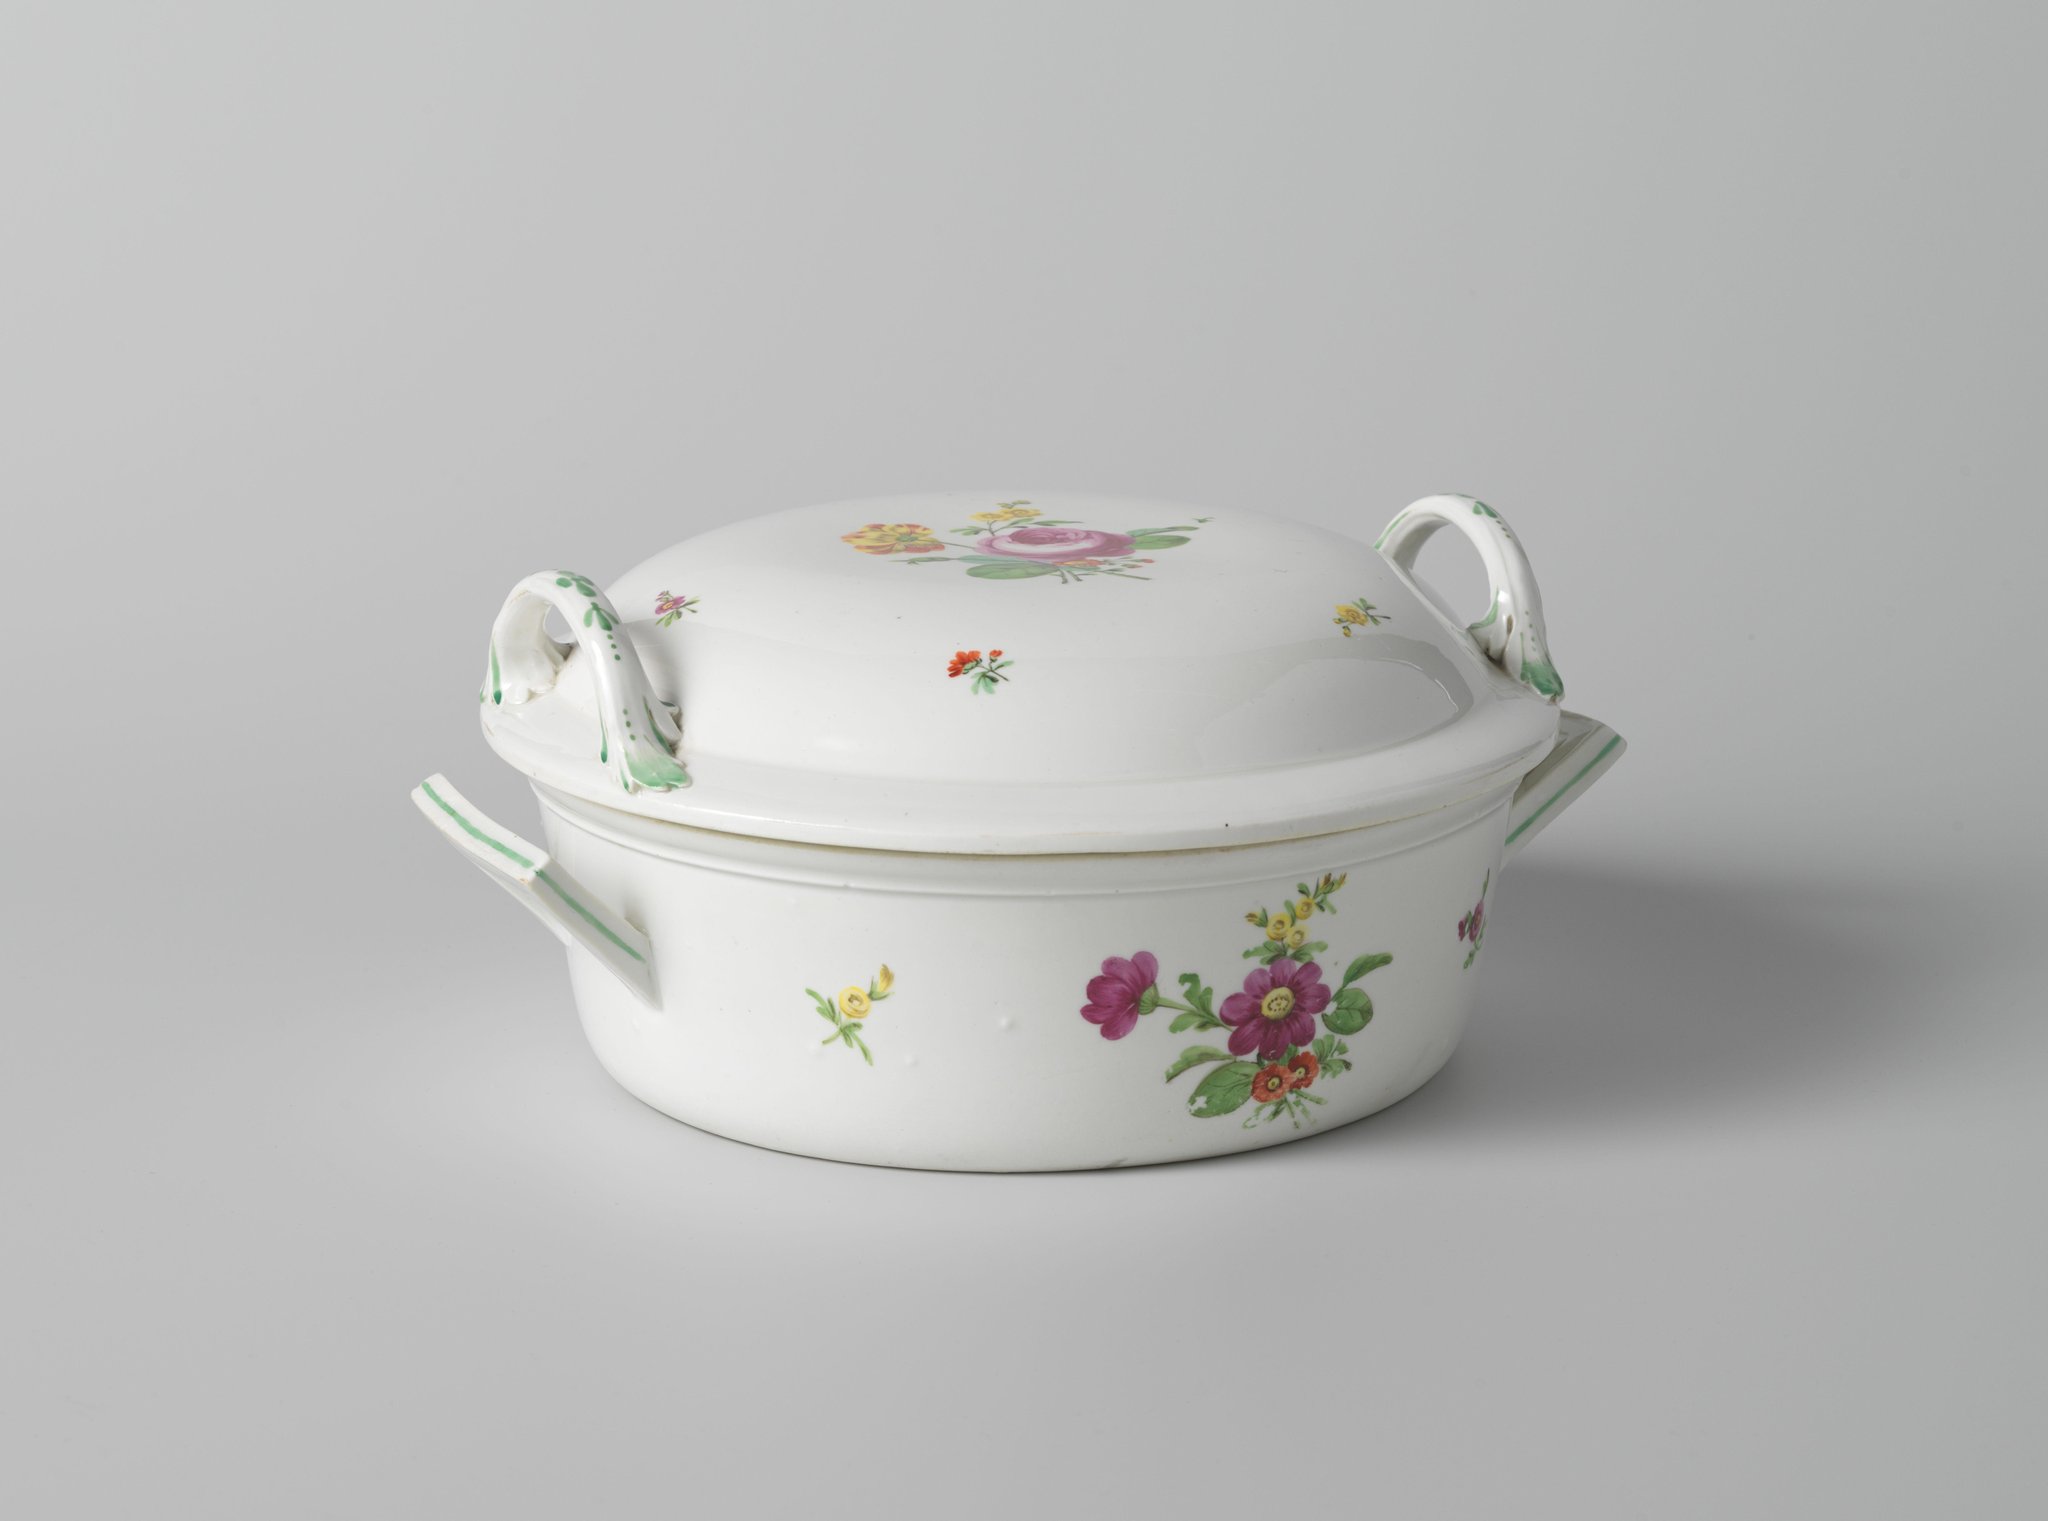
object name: service set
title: Tureen with bouquets and flower sprays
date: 1800-1849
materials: glaze, paint, porcelain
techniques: firing, forming, turning, vitrification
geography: vienna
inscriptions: mark: ‘schild’